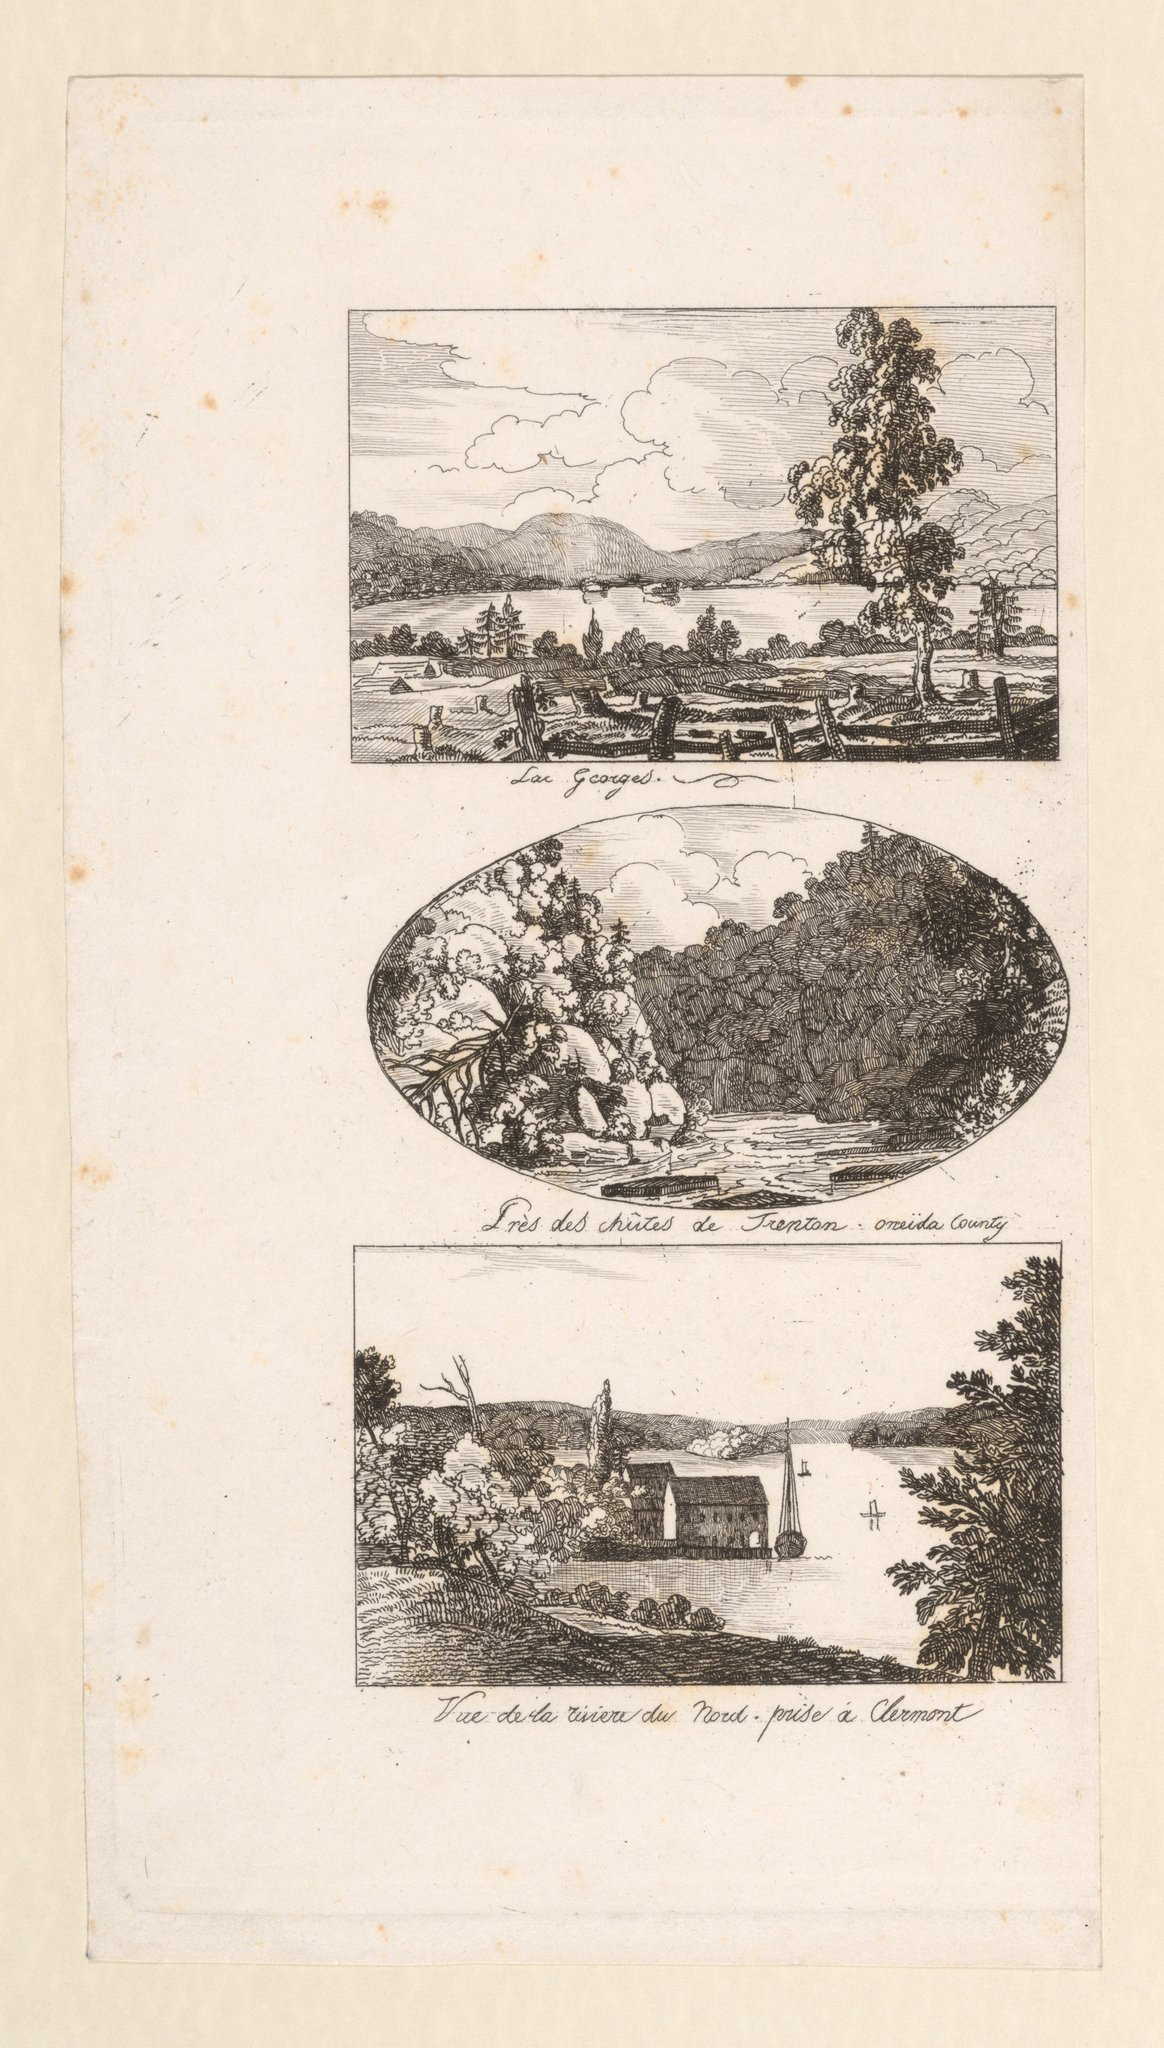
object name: print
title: Vues d'Amerique: Lac Georges; Près des chûtes de Trenton, Oneida County; Vue de la rivière du Nord, prise à Clermont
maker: charlotte bonaparte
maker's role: artist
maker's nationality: french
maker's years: 1802-1839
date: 1826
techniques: etching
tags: landscapes